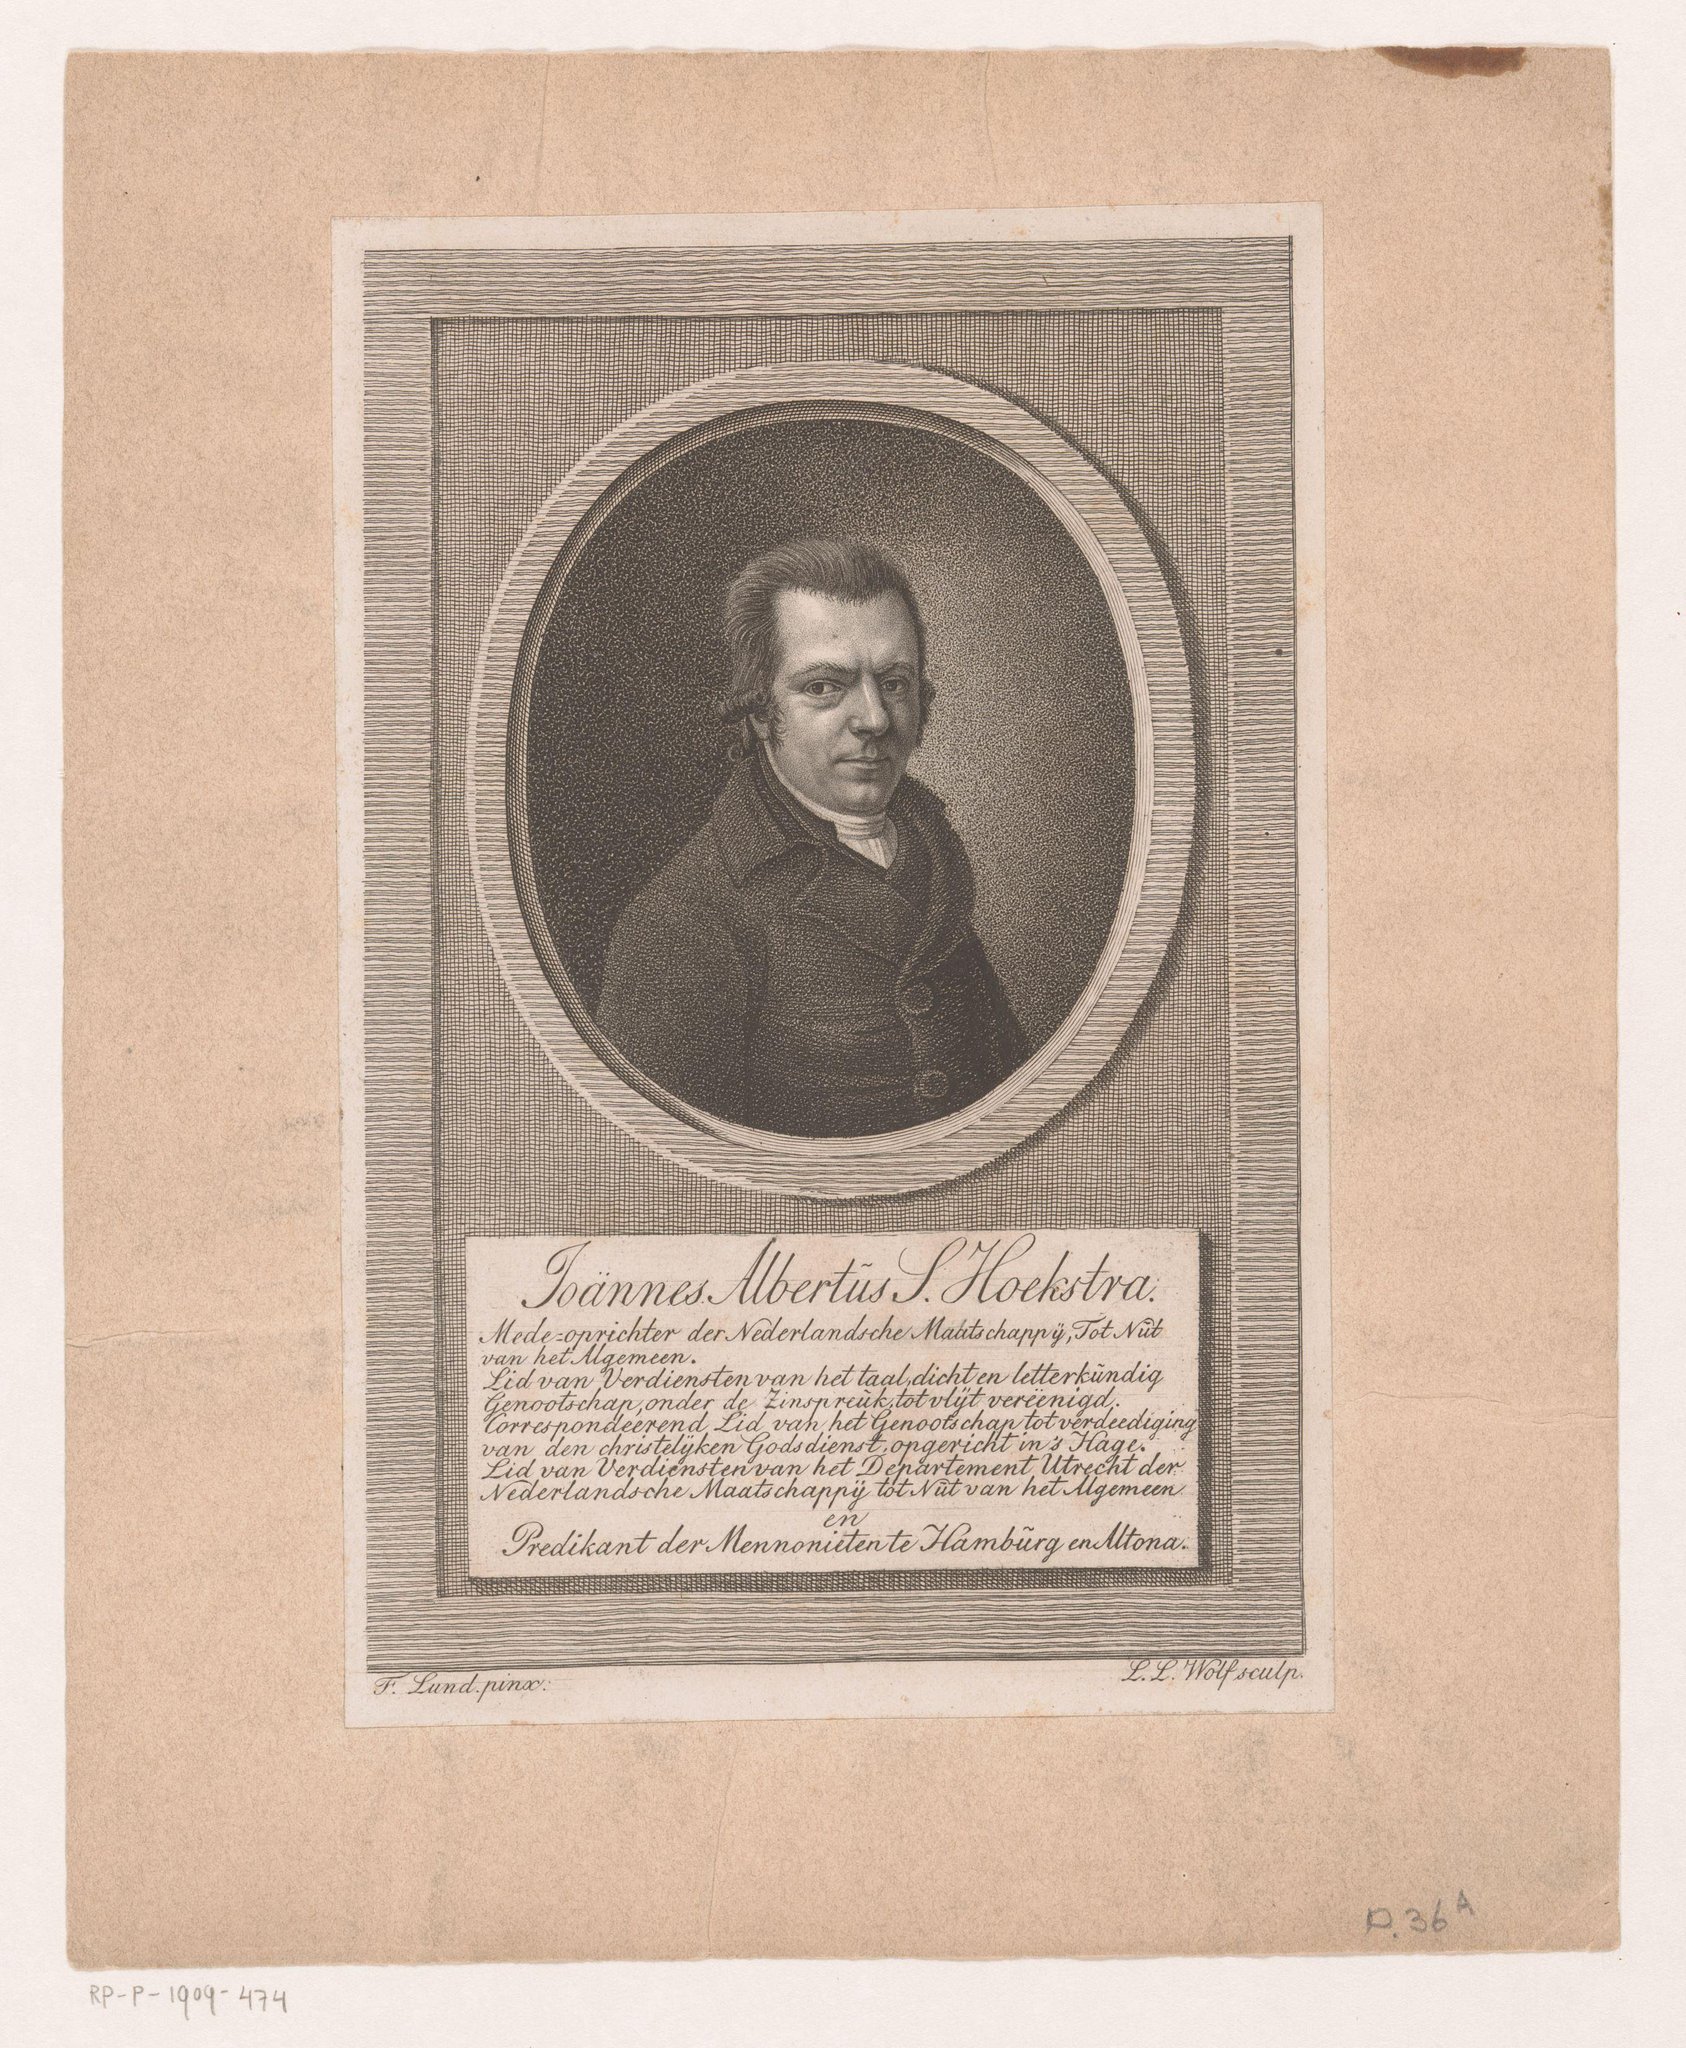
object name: print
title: Portret van Johannes Albertus Hoekstra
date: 1793-1840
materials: paper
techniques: engraving, etching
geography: germany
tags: johannes albertus hoekstra, historical persons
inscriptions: collector's mark: Lugt 2228